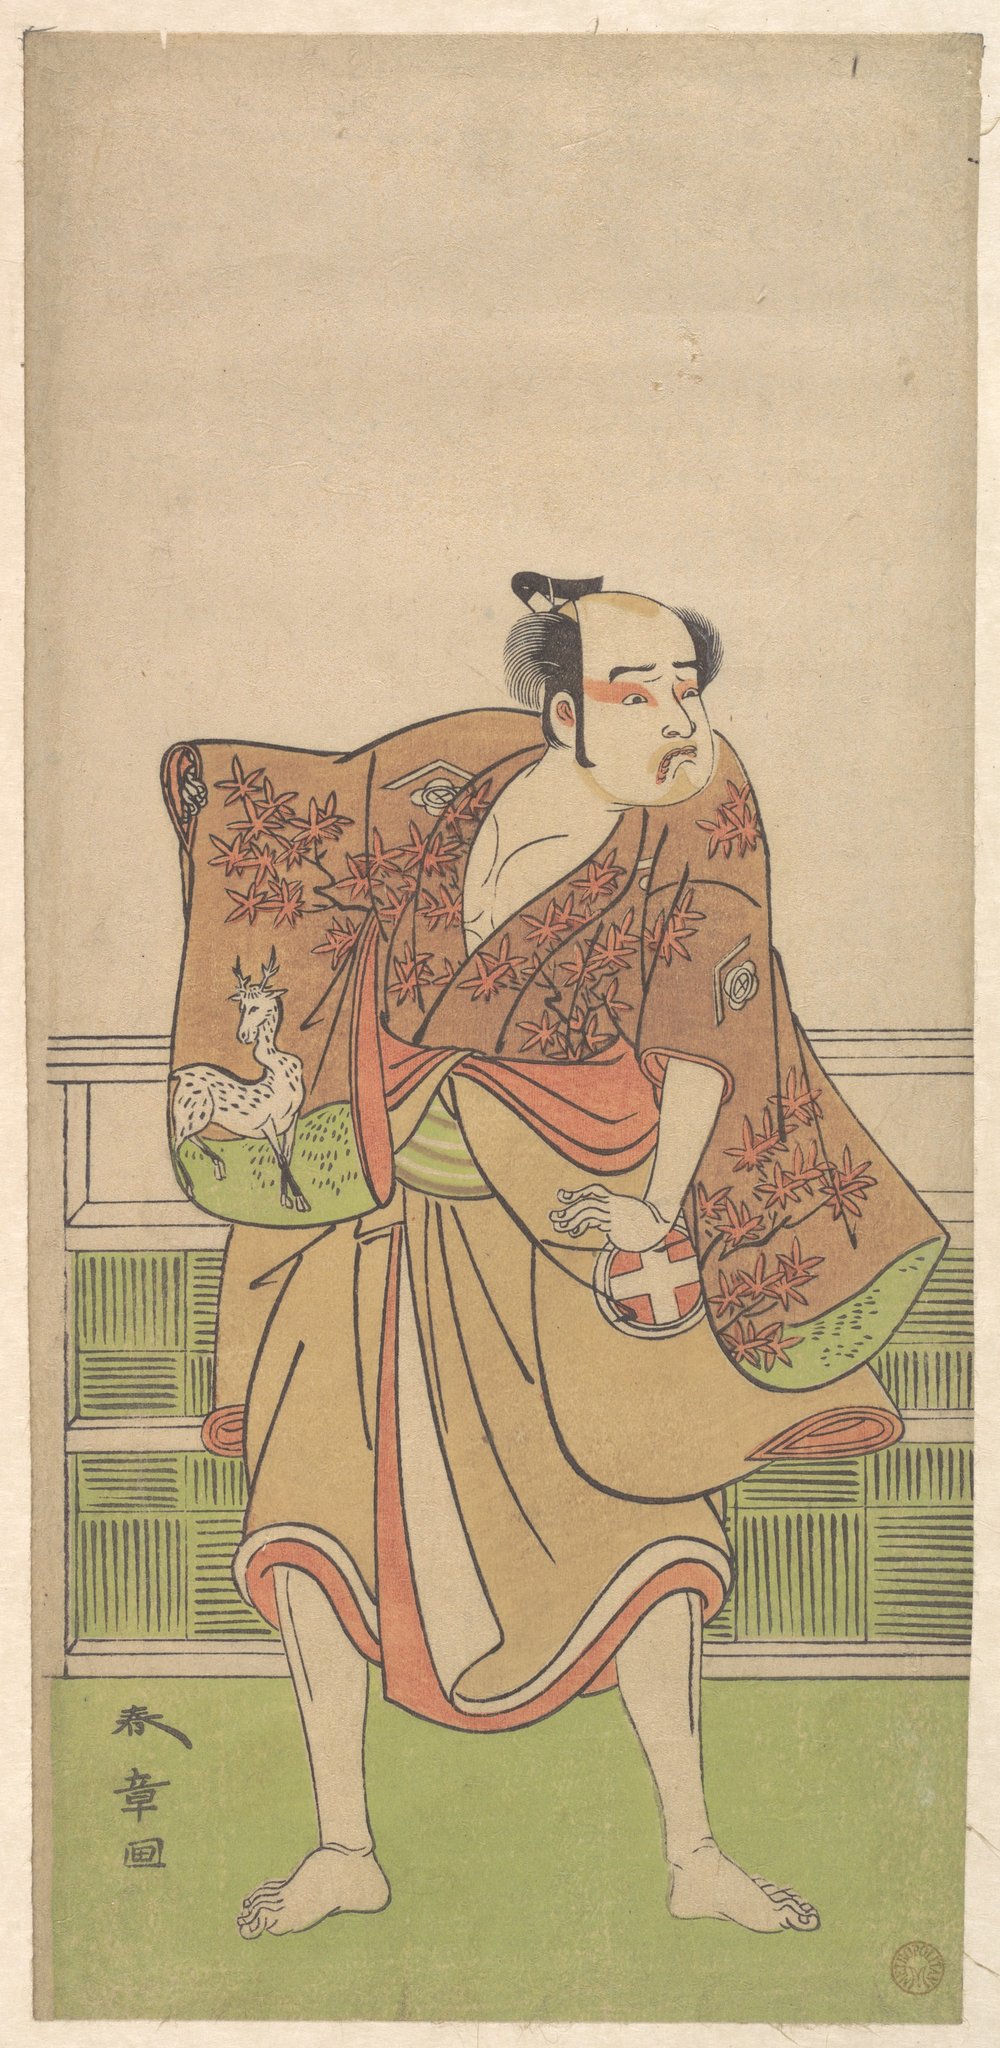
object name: woodblock print nishiki e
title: Ōtani Hiroemon in the role of Gokumon no Shobei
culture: japanese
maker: katsukawa shunshō 勝川春章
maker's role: artist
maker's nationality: japanese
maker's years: 1726-1792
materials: ink, paper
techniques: nishiki e, woodblock print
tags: men,actors